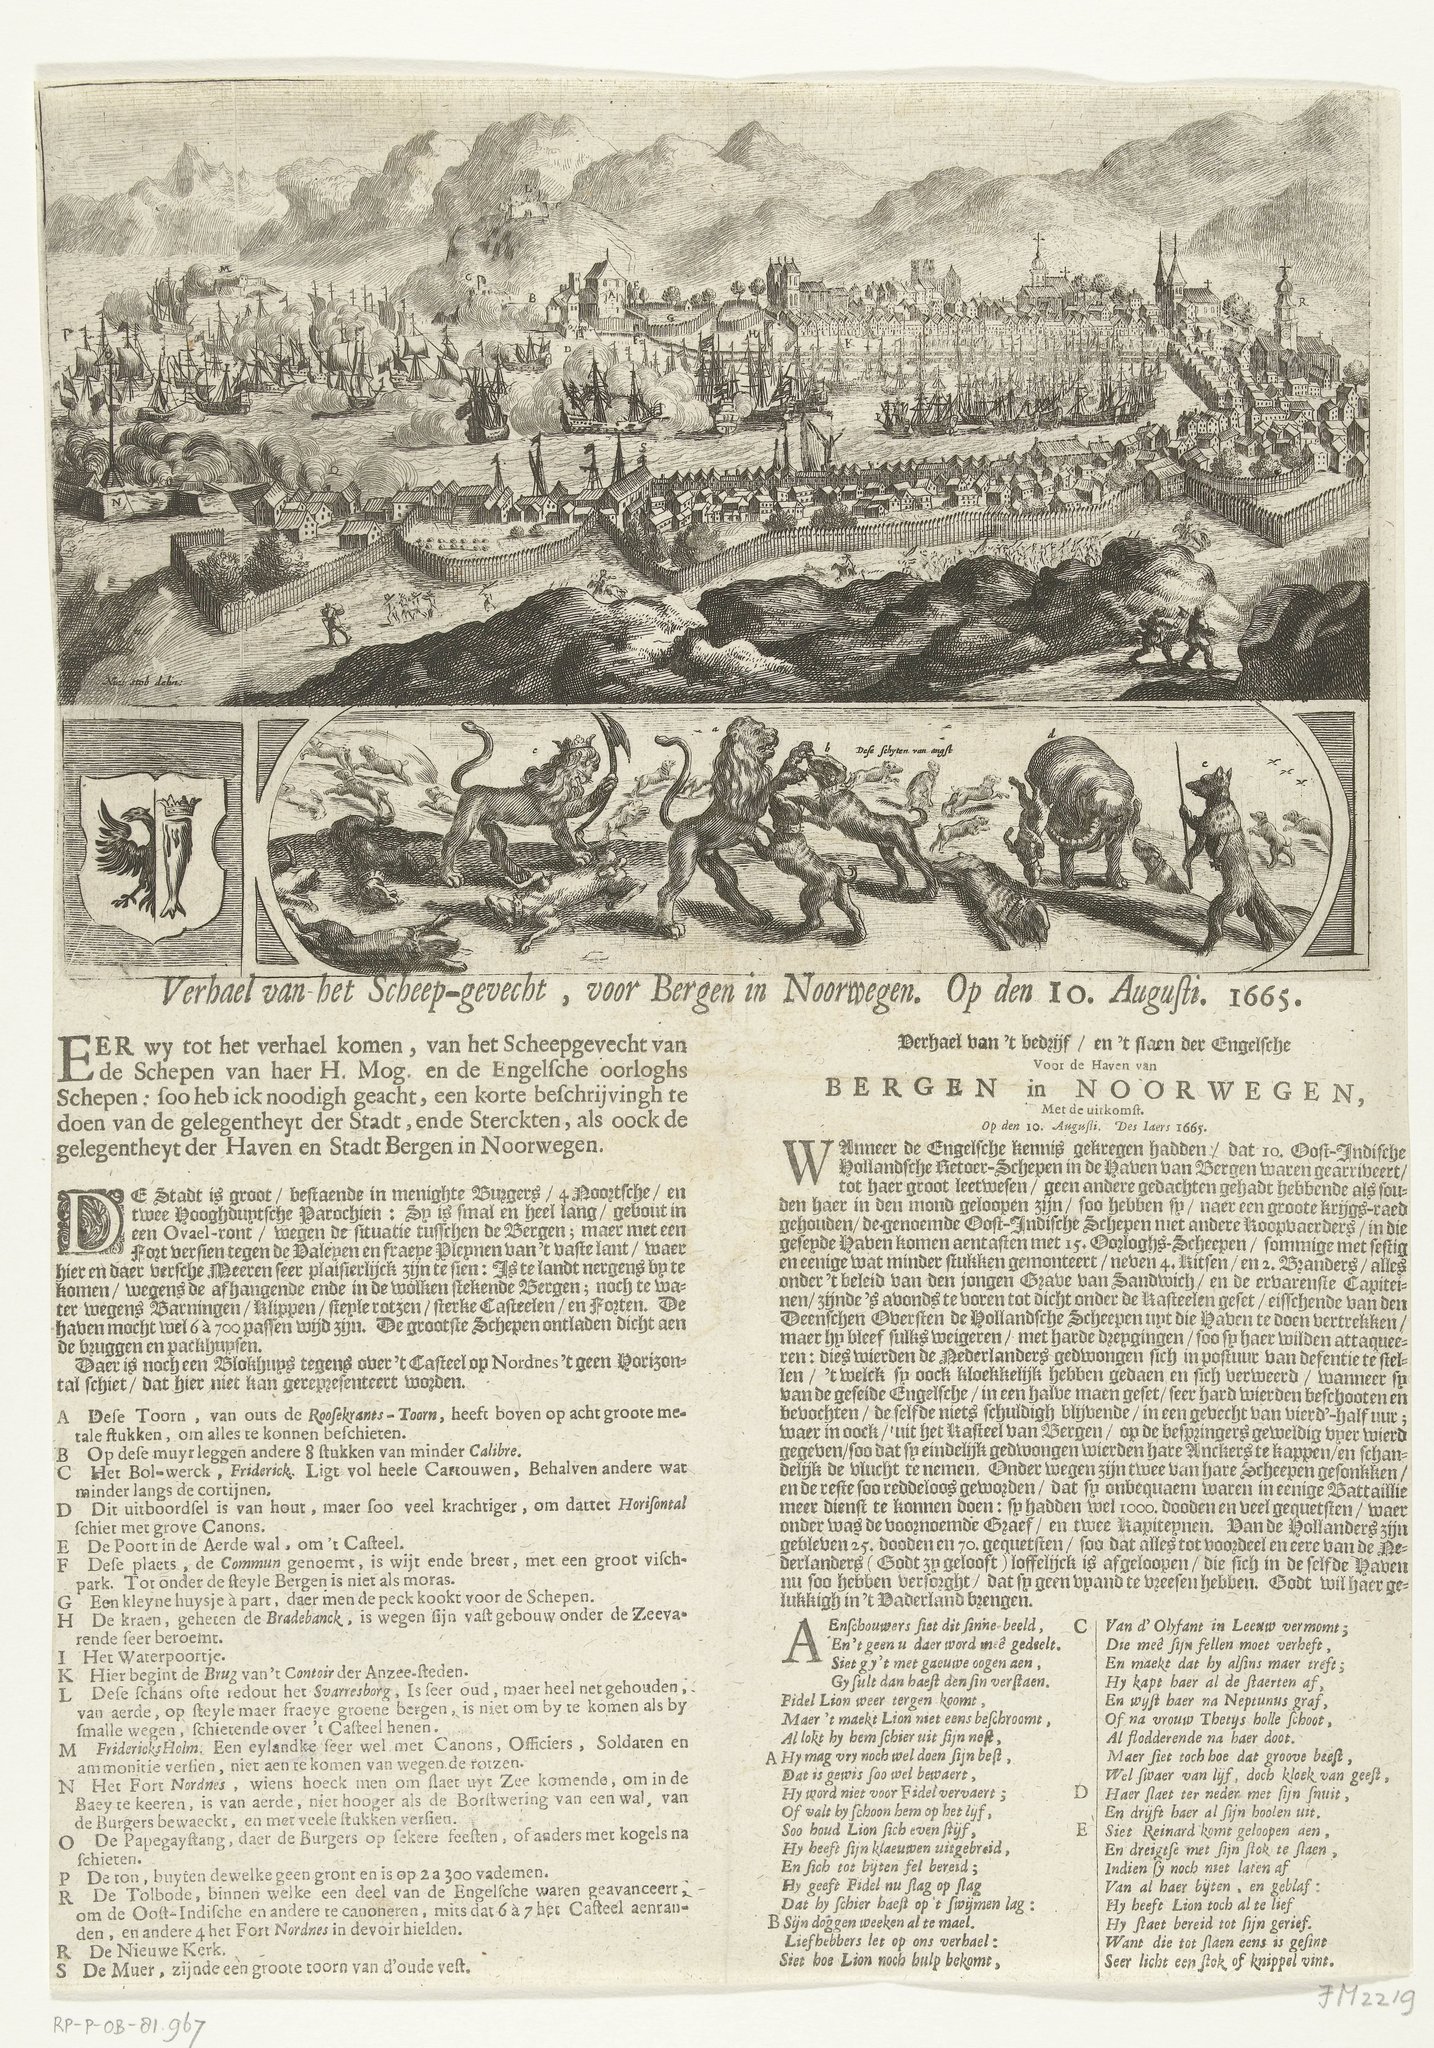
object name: print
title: Verhael van het Scheep-gevecht, voor Bergen in Noorwegen. Op den 10 Augusti. 1665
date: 1665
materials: paper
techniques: etching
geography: northern netherlands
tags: animals acting as human beings, battle (+ naval force)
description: Slag bij Bergen (Noorwegen), 10 augustus 1665. Aanval door de Engelse vloot op de Hollandse koopvaardijvloot gelegen in de neutrale haven van Bergen in Noorwegen. De Engelsen worden door De Ruyter verjaagd. Met een allegorische voorstelling van de strijd verbeeld door dieren: de Nederlandse Leeuw in gevecht met twee Engelse doggen, met links en rechts andere dieren waaronder een olifant (Denemarken) en Reinaart de Vos (Zweden). Onder de plaat tekst in 2 kolommen in het Nederlands.